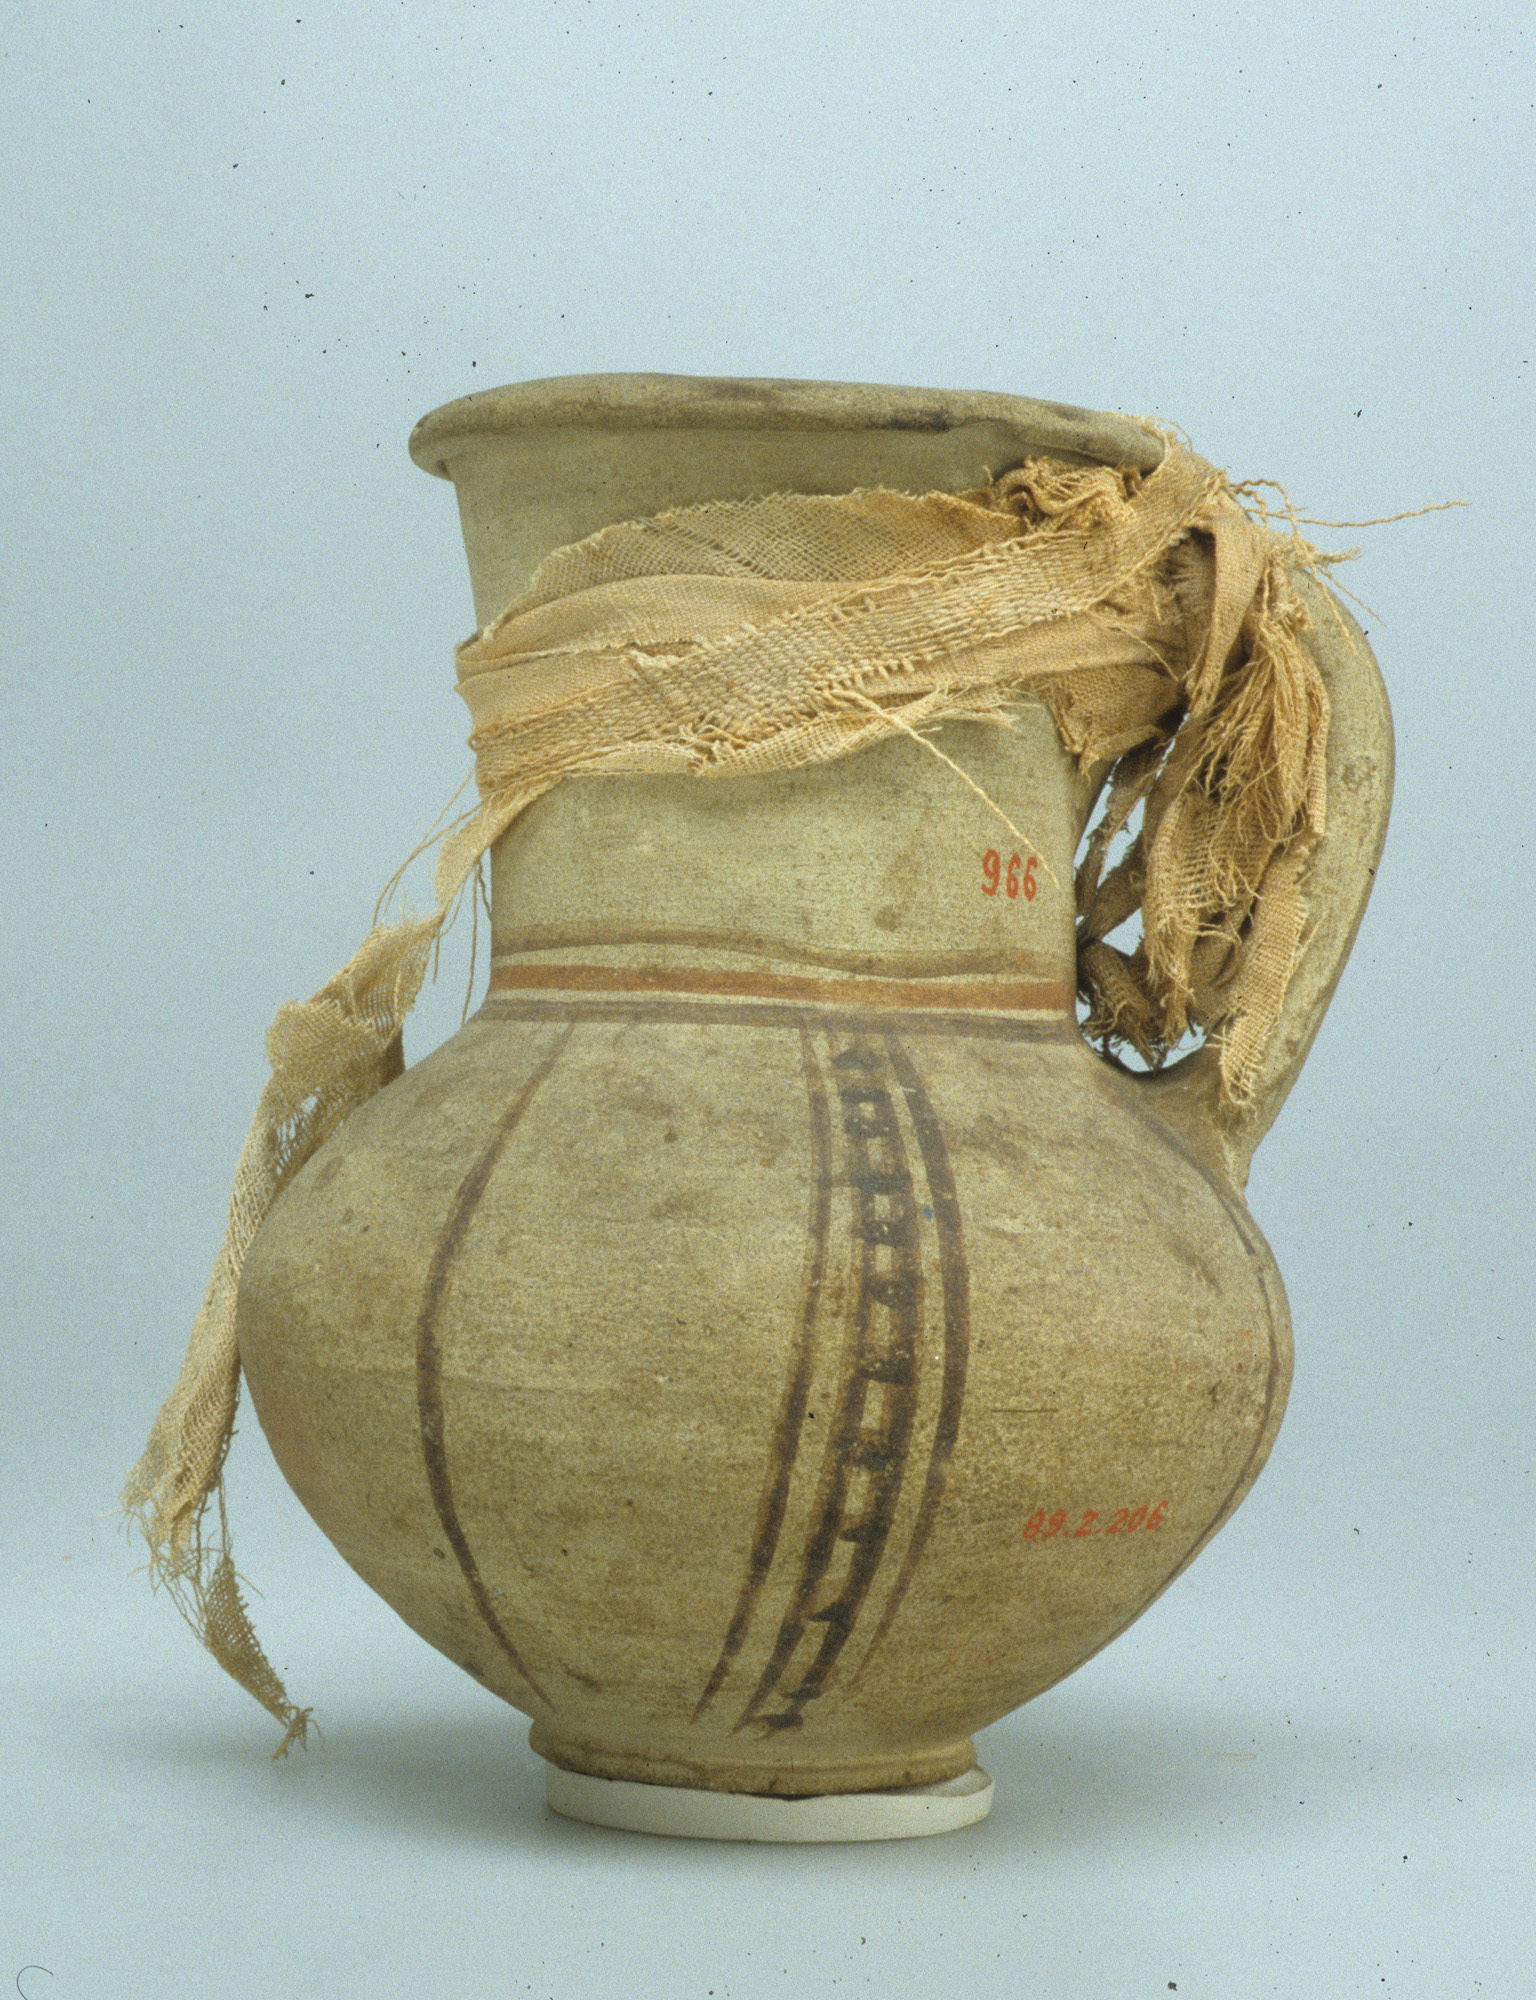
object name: jar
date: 1550-1295 BCE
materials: cord, pottery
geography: egypt